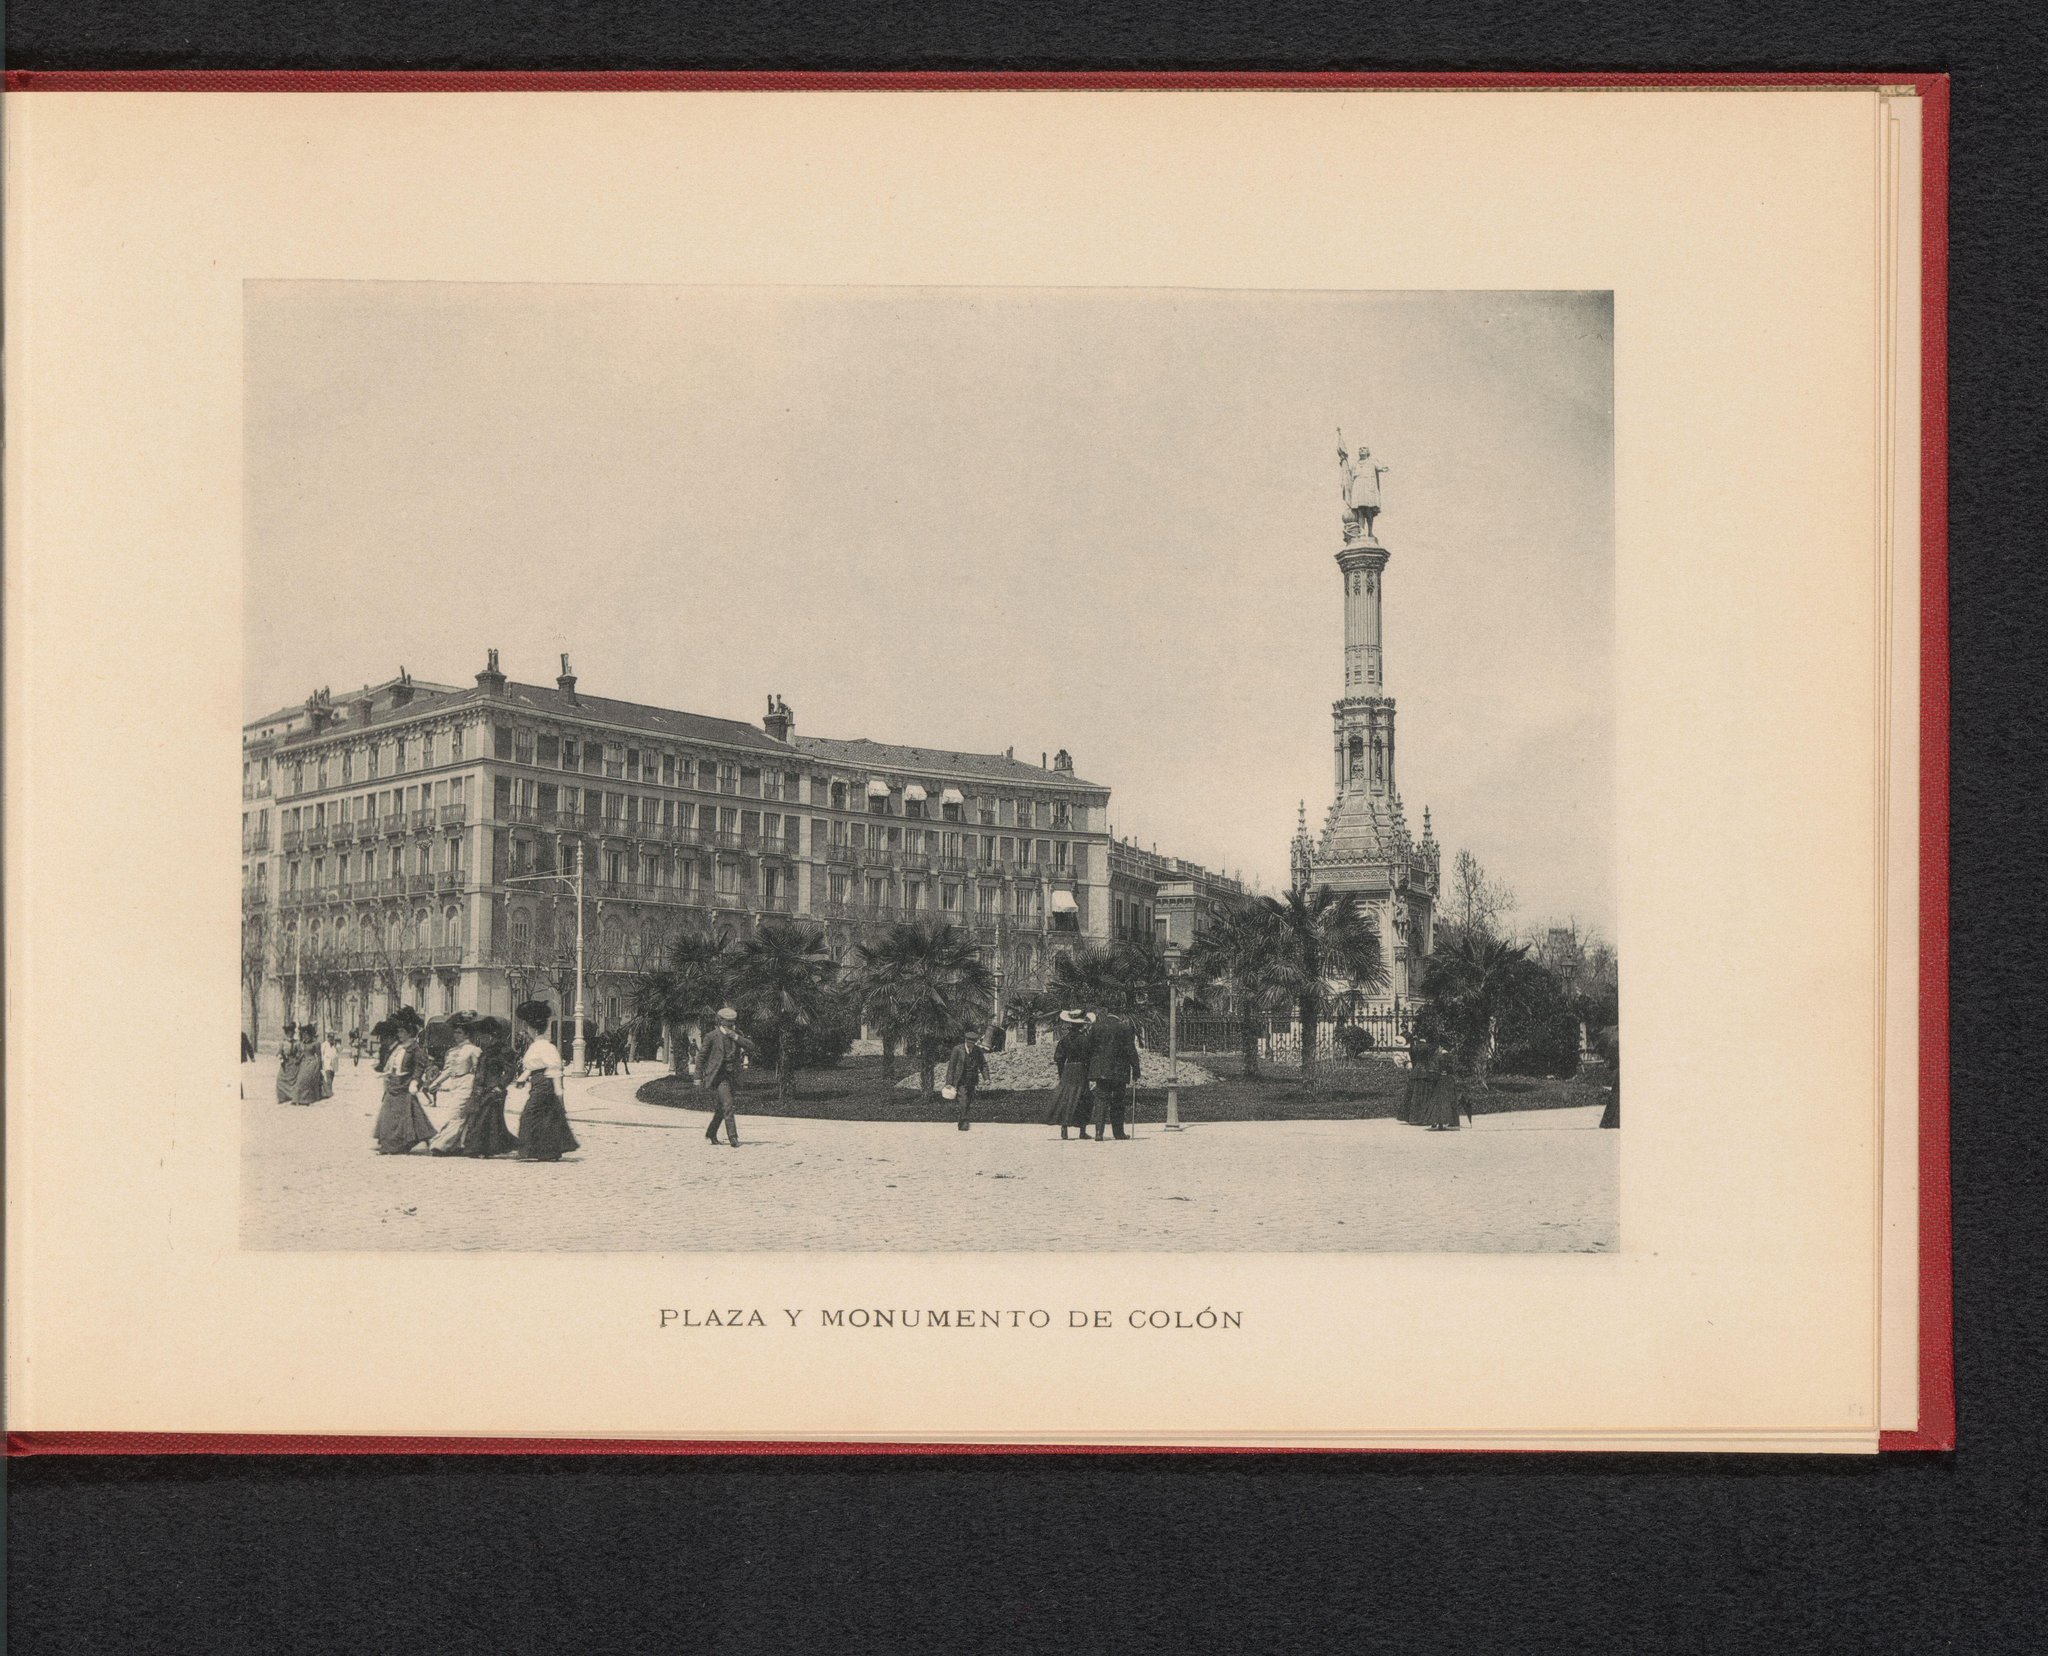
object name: photomechanical print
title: Gezicht op een monument voor Christoffel Columbus op het Plaza de Colón in Madrid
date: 1888-1898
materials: paper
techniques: photograph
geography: plaza de colón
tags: square, place, circus, etc., monument, statue